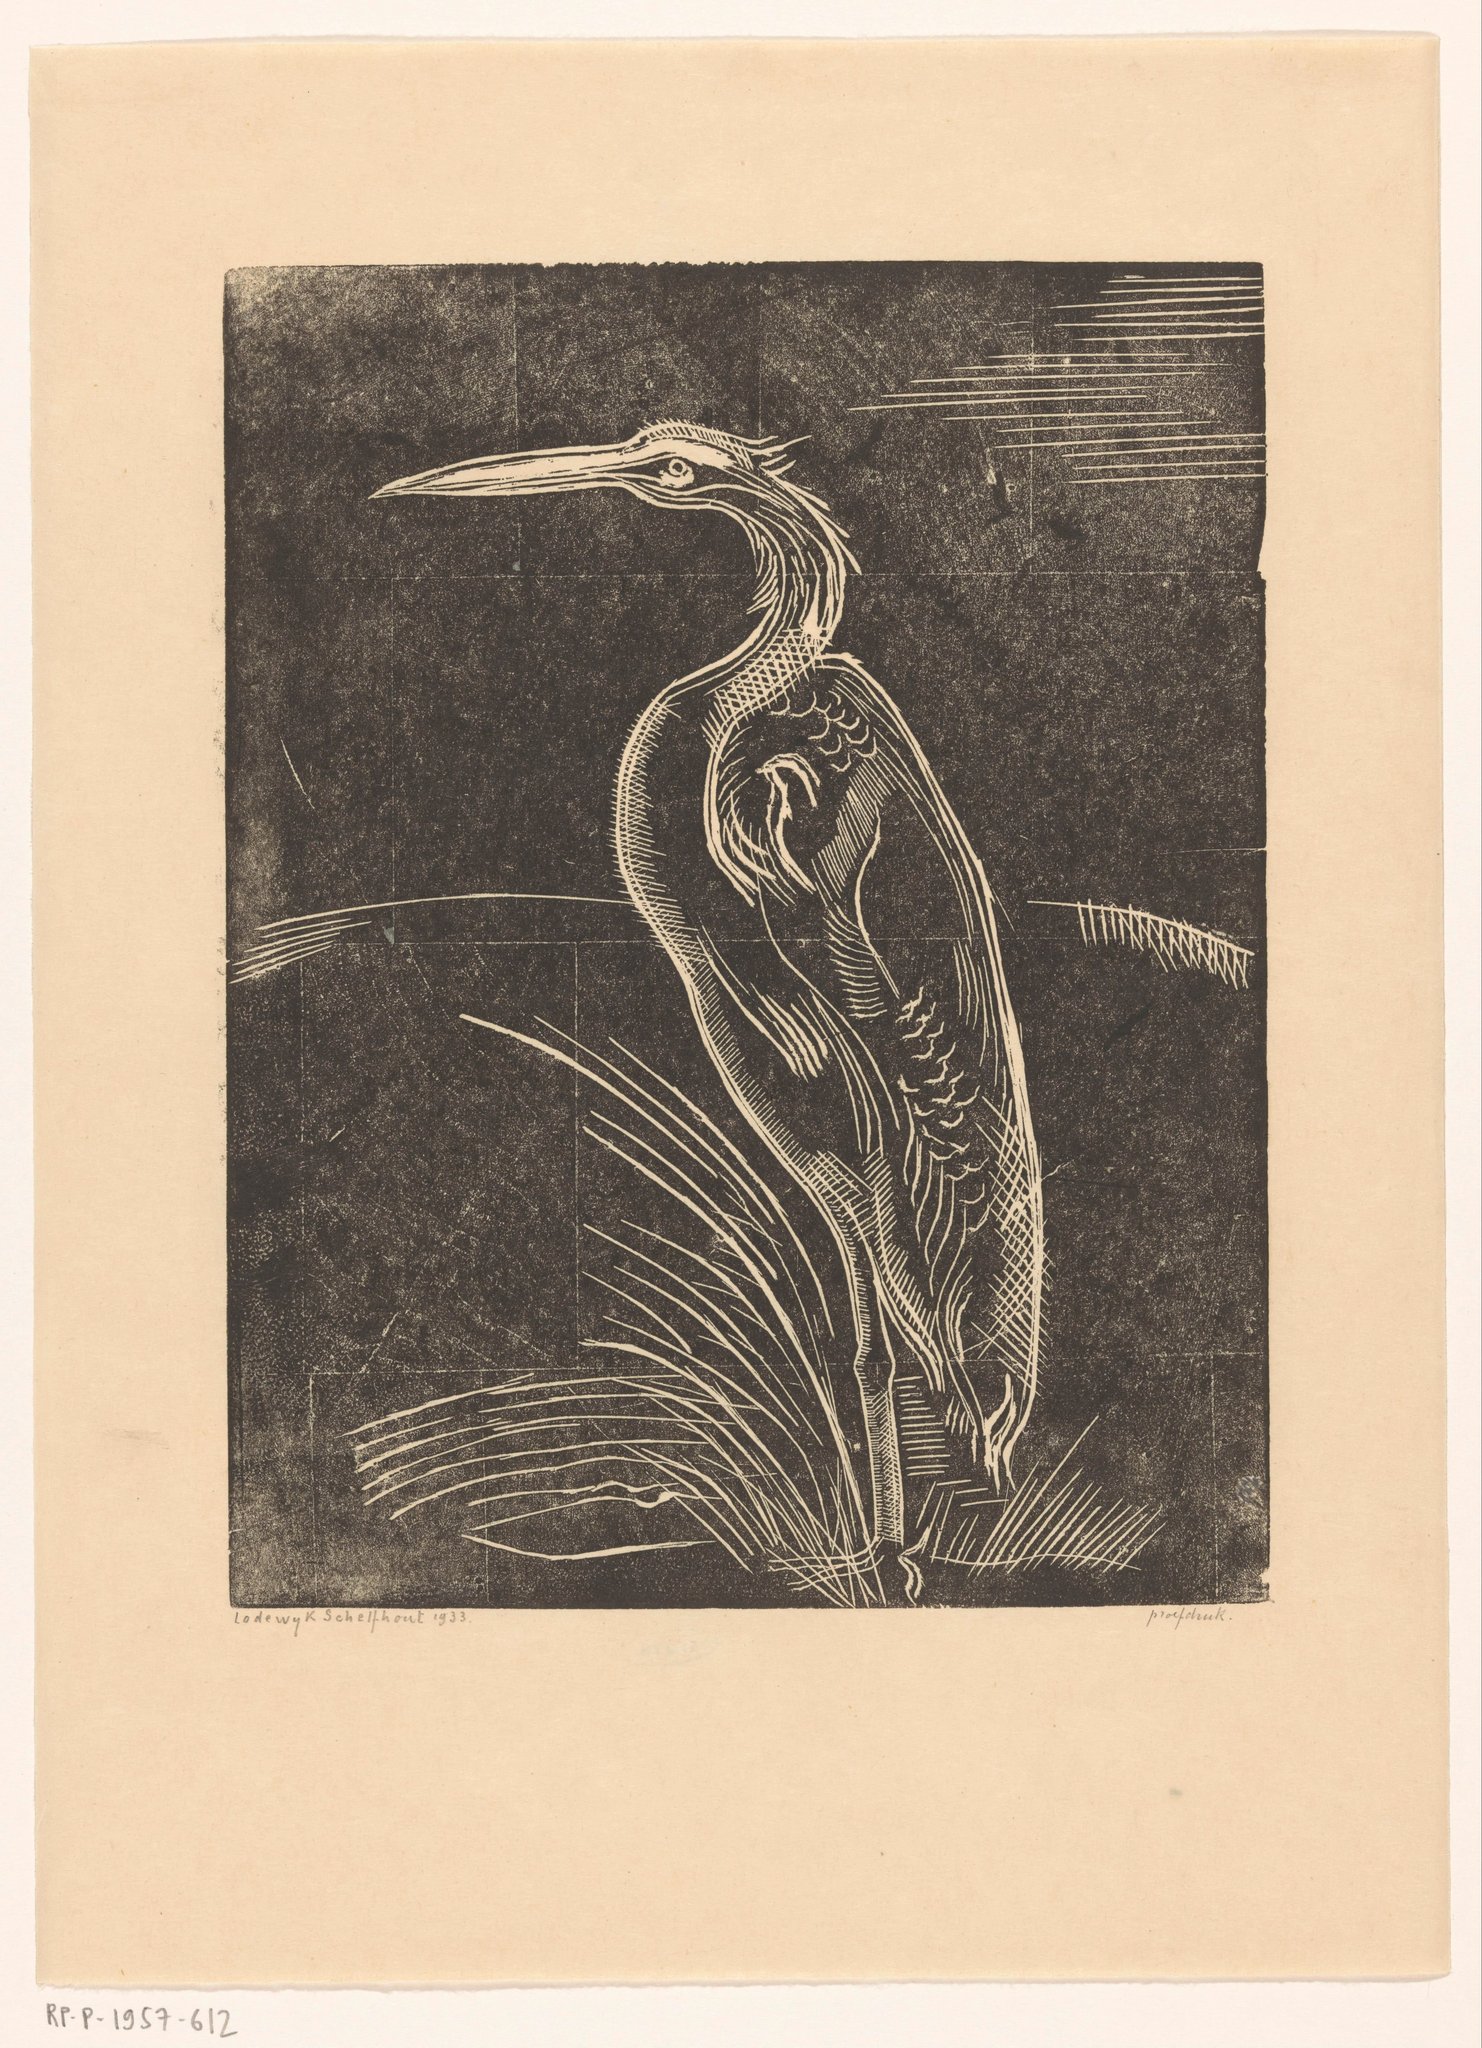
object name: print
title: Reiger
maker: lodewijk schelfhout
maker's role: draughtsman, print maker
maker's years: 1881-1943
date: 1933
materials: paper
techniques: woodcut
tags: shore-birds and wading-birds: heron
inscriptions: collector's mark: Lugt 2228